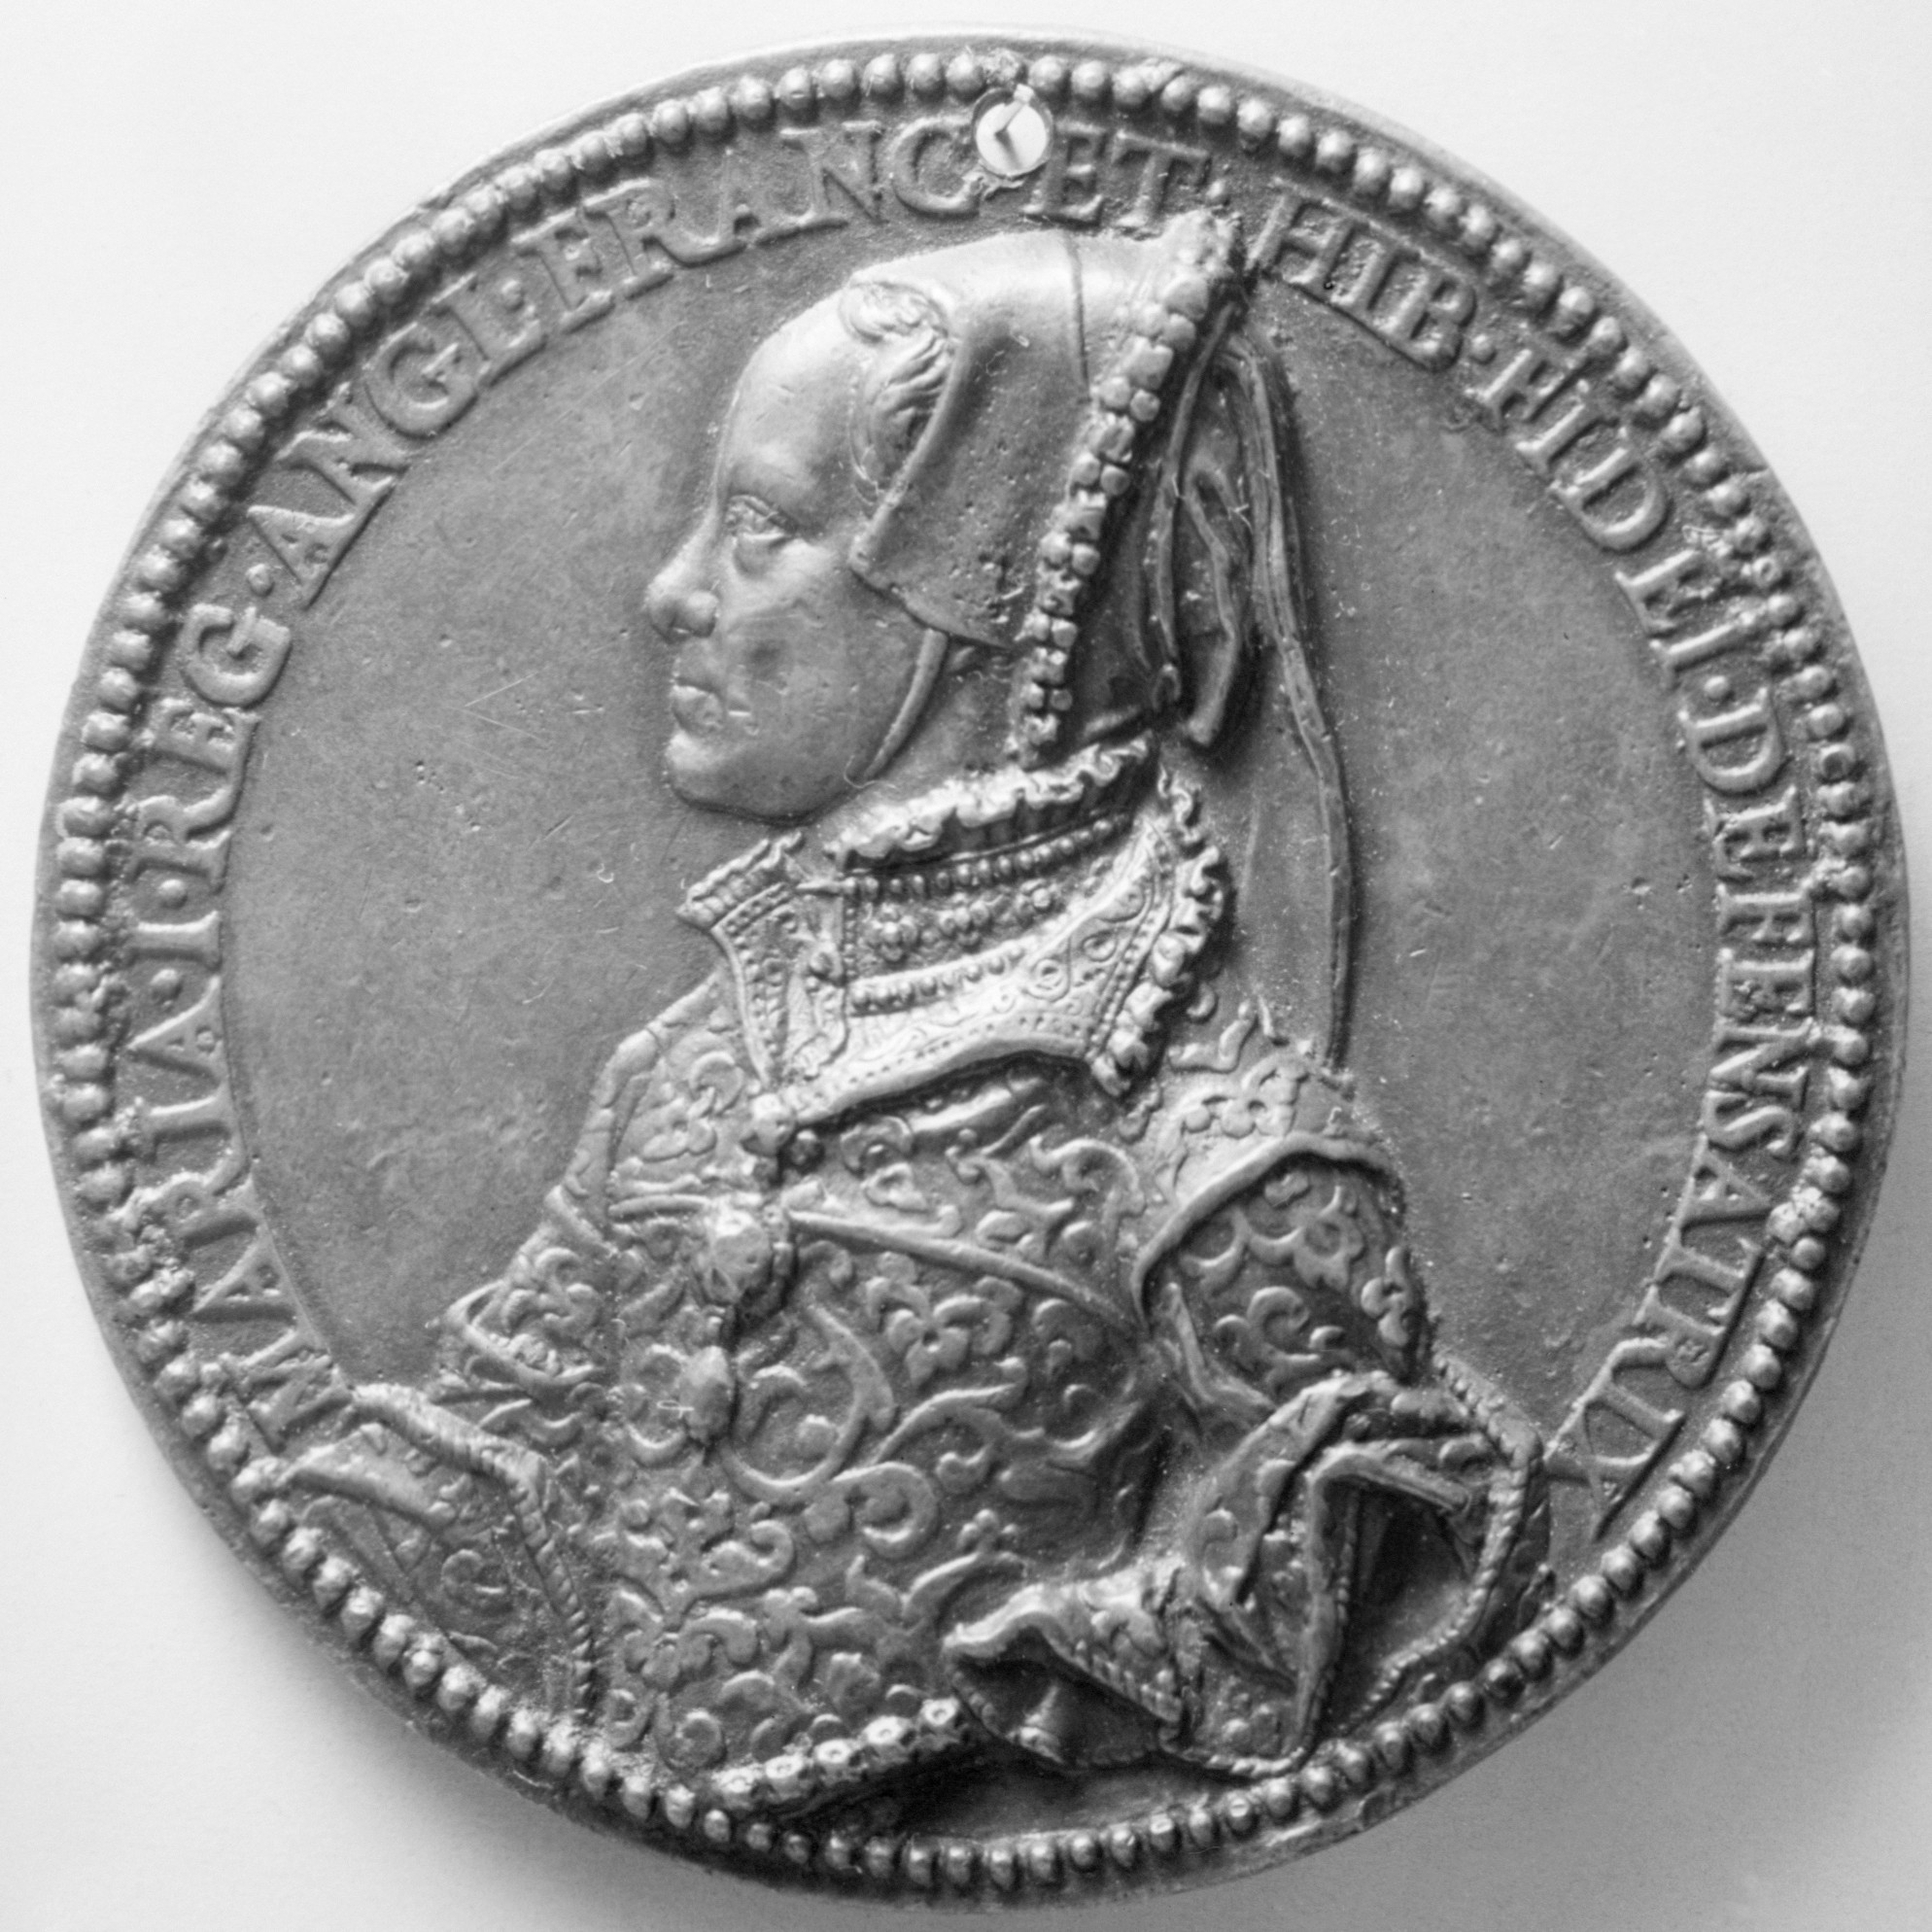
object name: medal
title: Mary Tudor, Queen of England (1516-1558, r. 1553, m. 1554), Commemorating her Marriage to Philip of Spain (1527-1598, r. 1556-98)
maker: jacopo nizolla da trezzo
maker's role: artist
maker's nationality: italian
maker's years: 1515-1589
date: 1555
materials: bronze, patina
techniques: casting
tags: queens,profiles,women